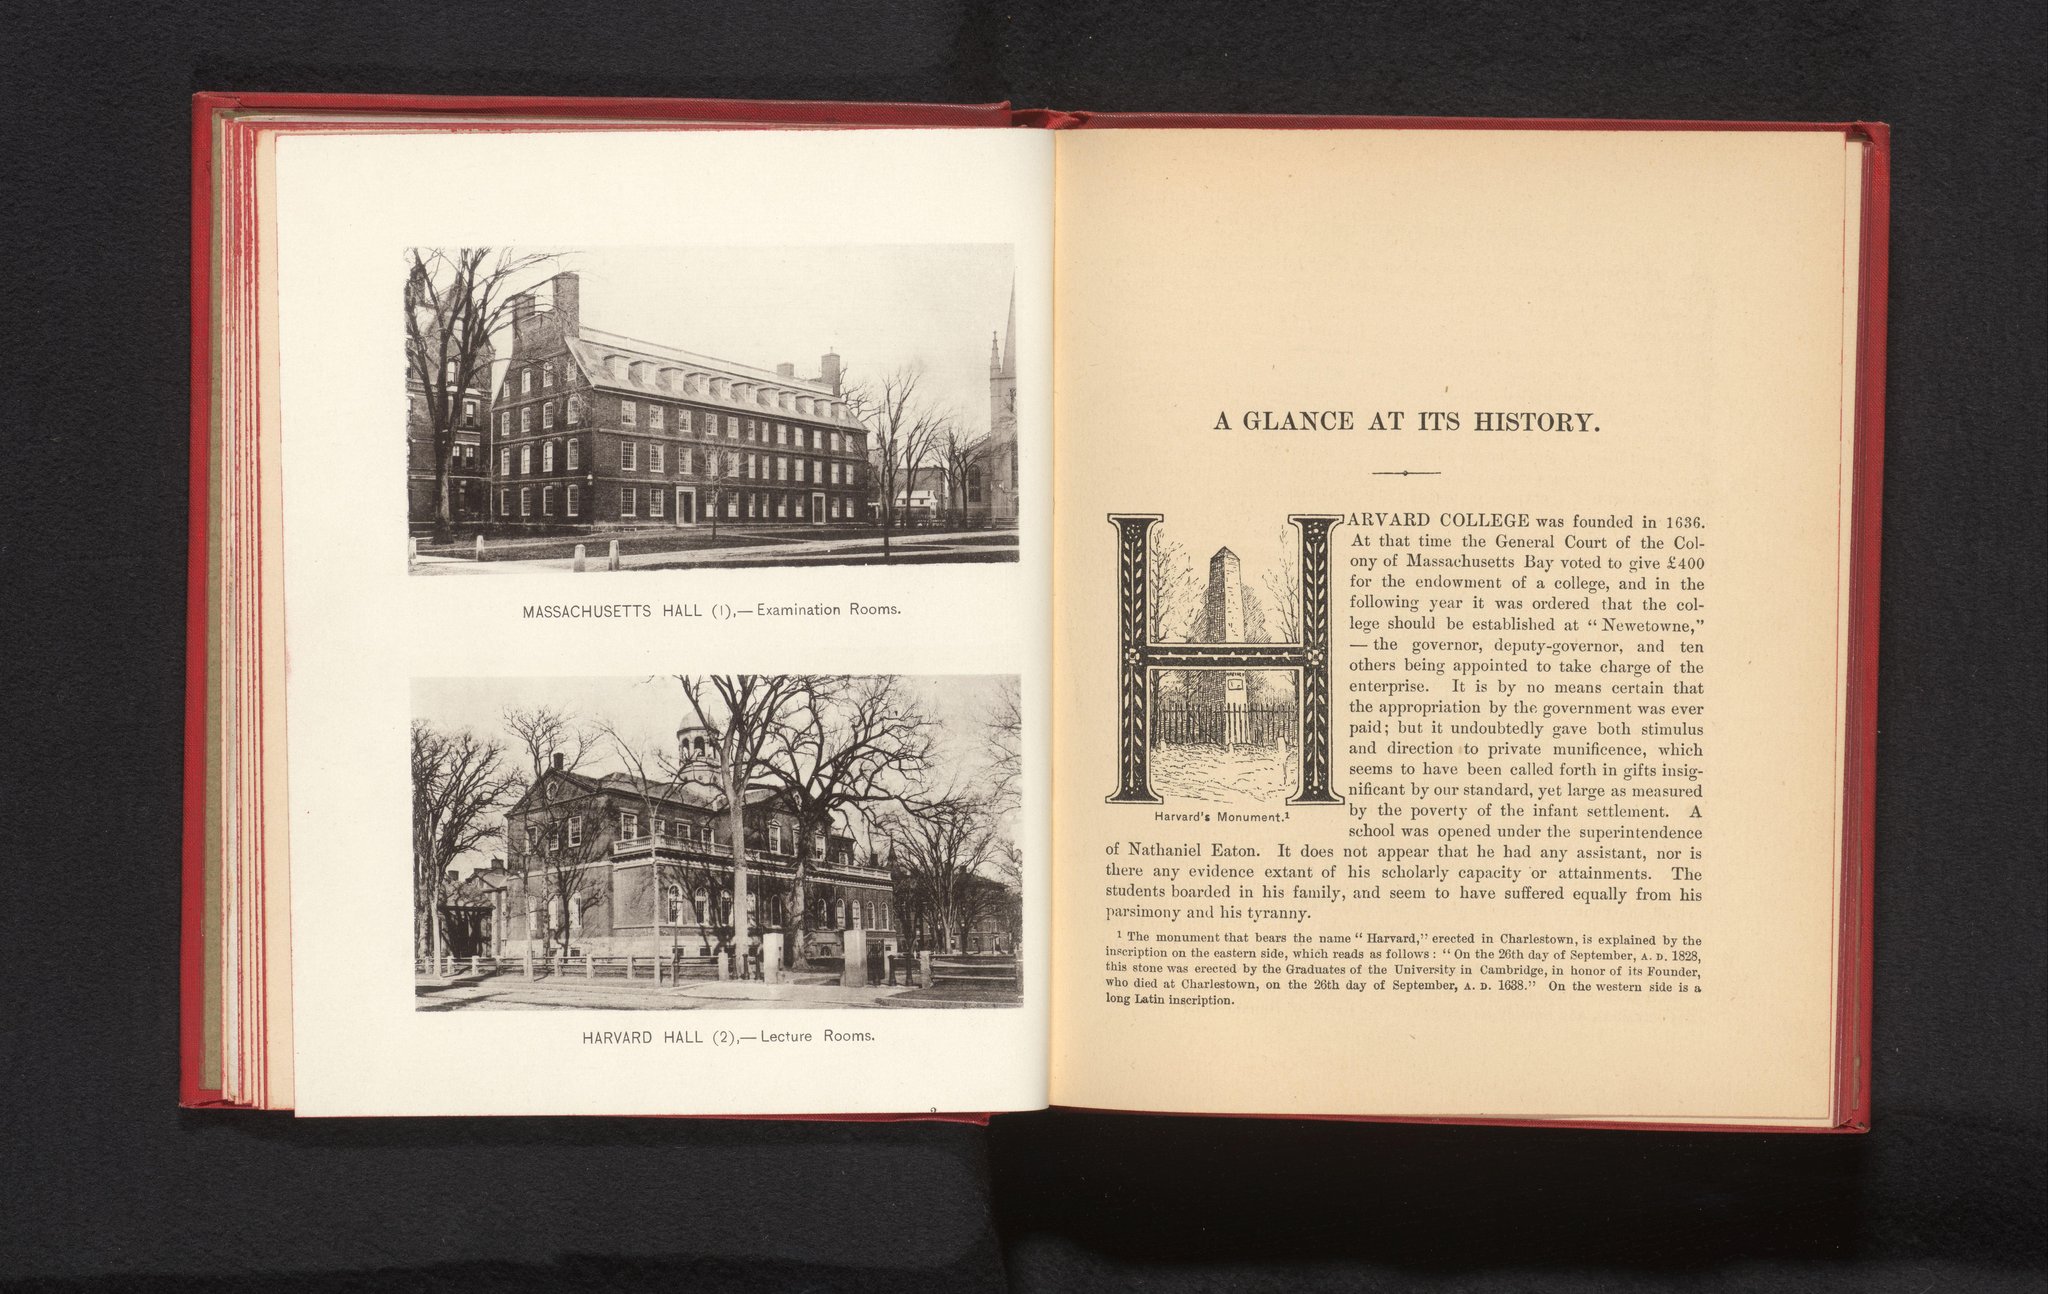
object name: page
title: Massachusetts Hall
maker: Anonymous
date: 1881-1886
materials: paper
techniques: photograph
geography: cambridge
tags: university building, college, façade (of house or building)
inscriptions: number: ‘(1) (2)’